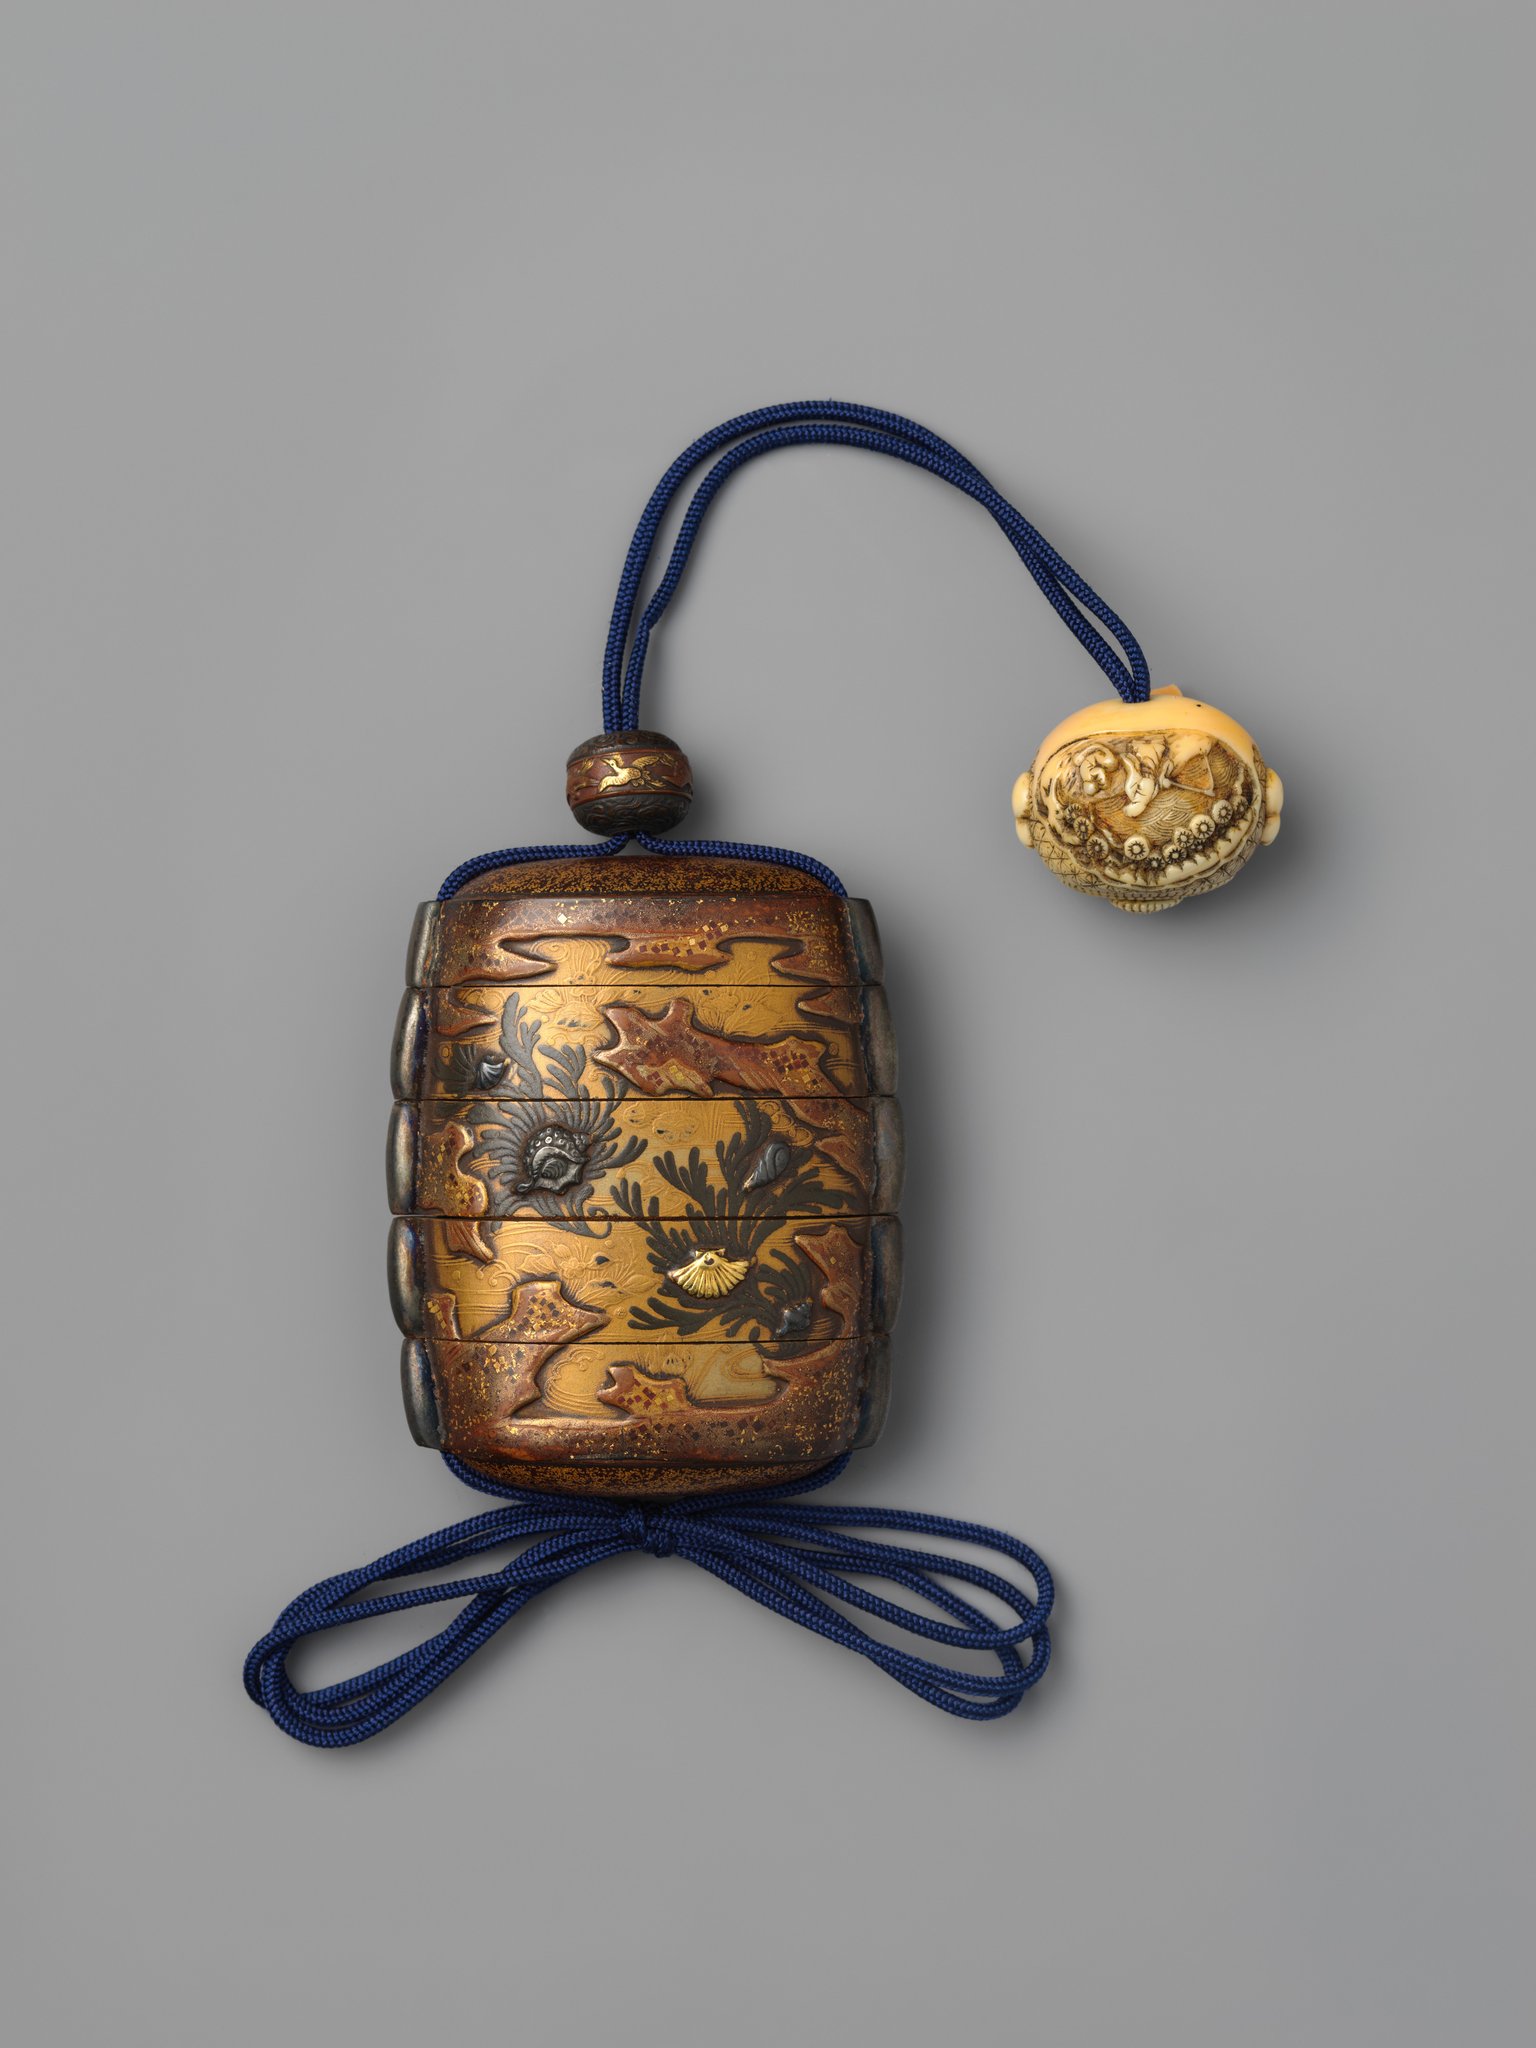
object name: inrō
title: Inrō with Shells and Seaweeds amid Rocks and Waves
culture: japanese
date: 1601-1800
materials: copper, cord, gold, gold foil, gold leaf, ivory, metal, silver, wood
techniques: carving, gilding, hiramakie, inlay, lacquer, maki-e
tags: shells